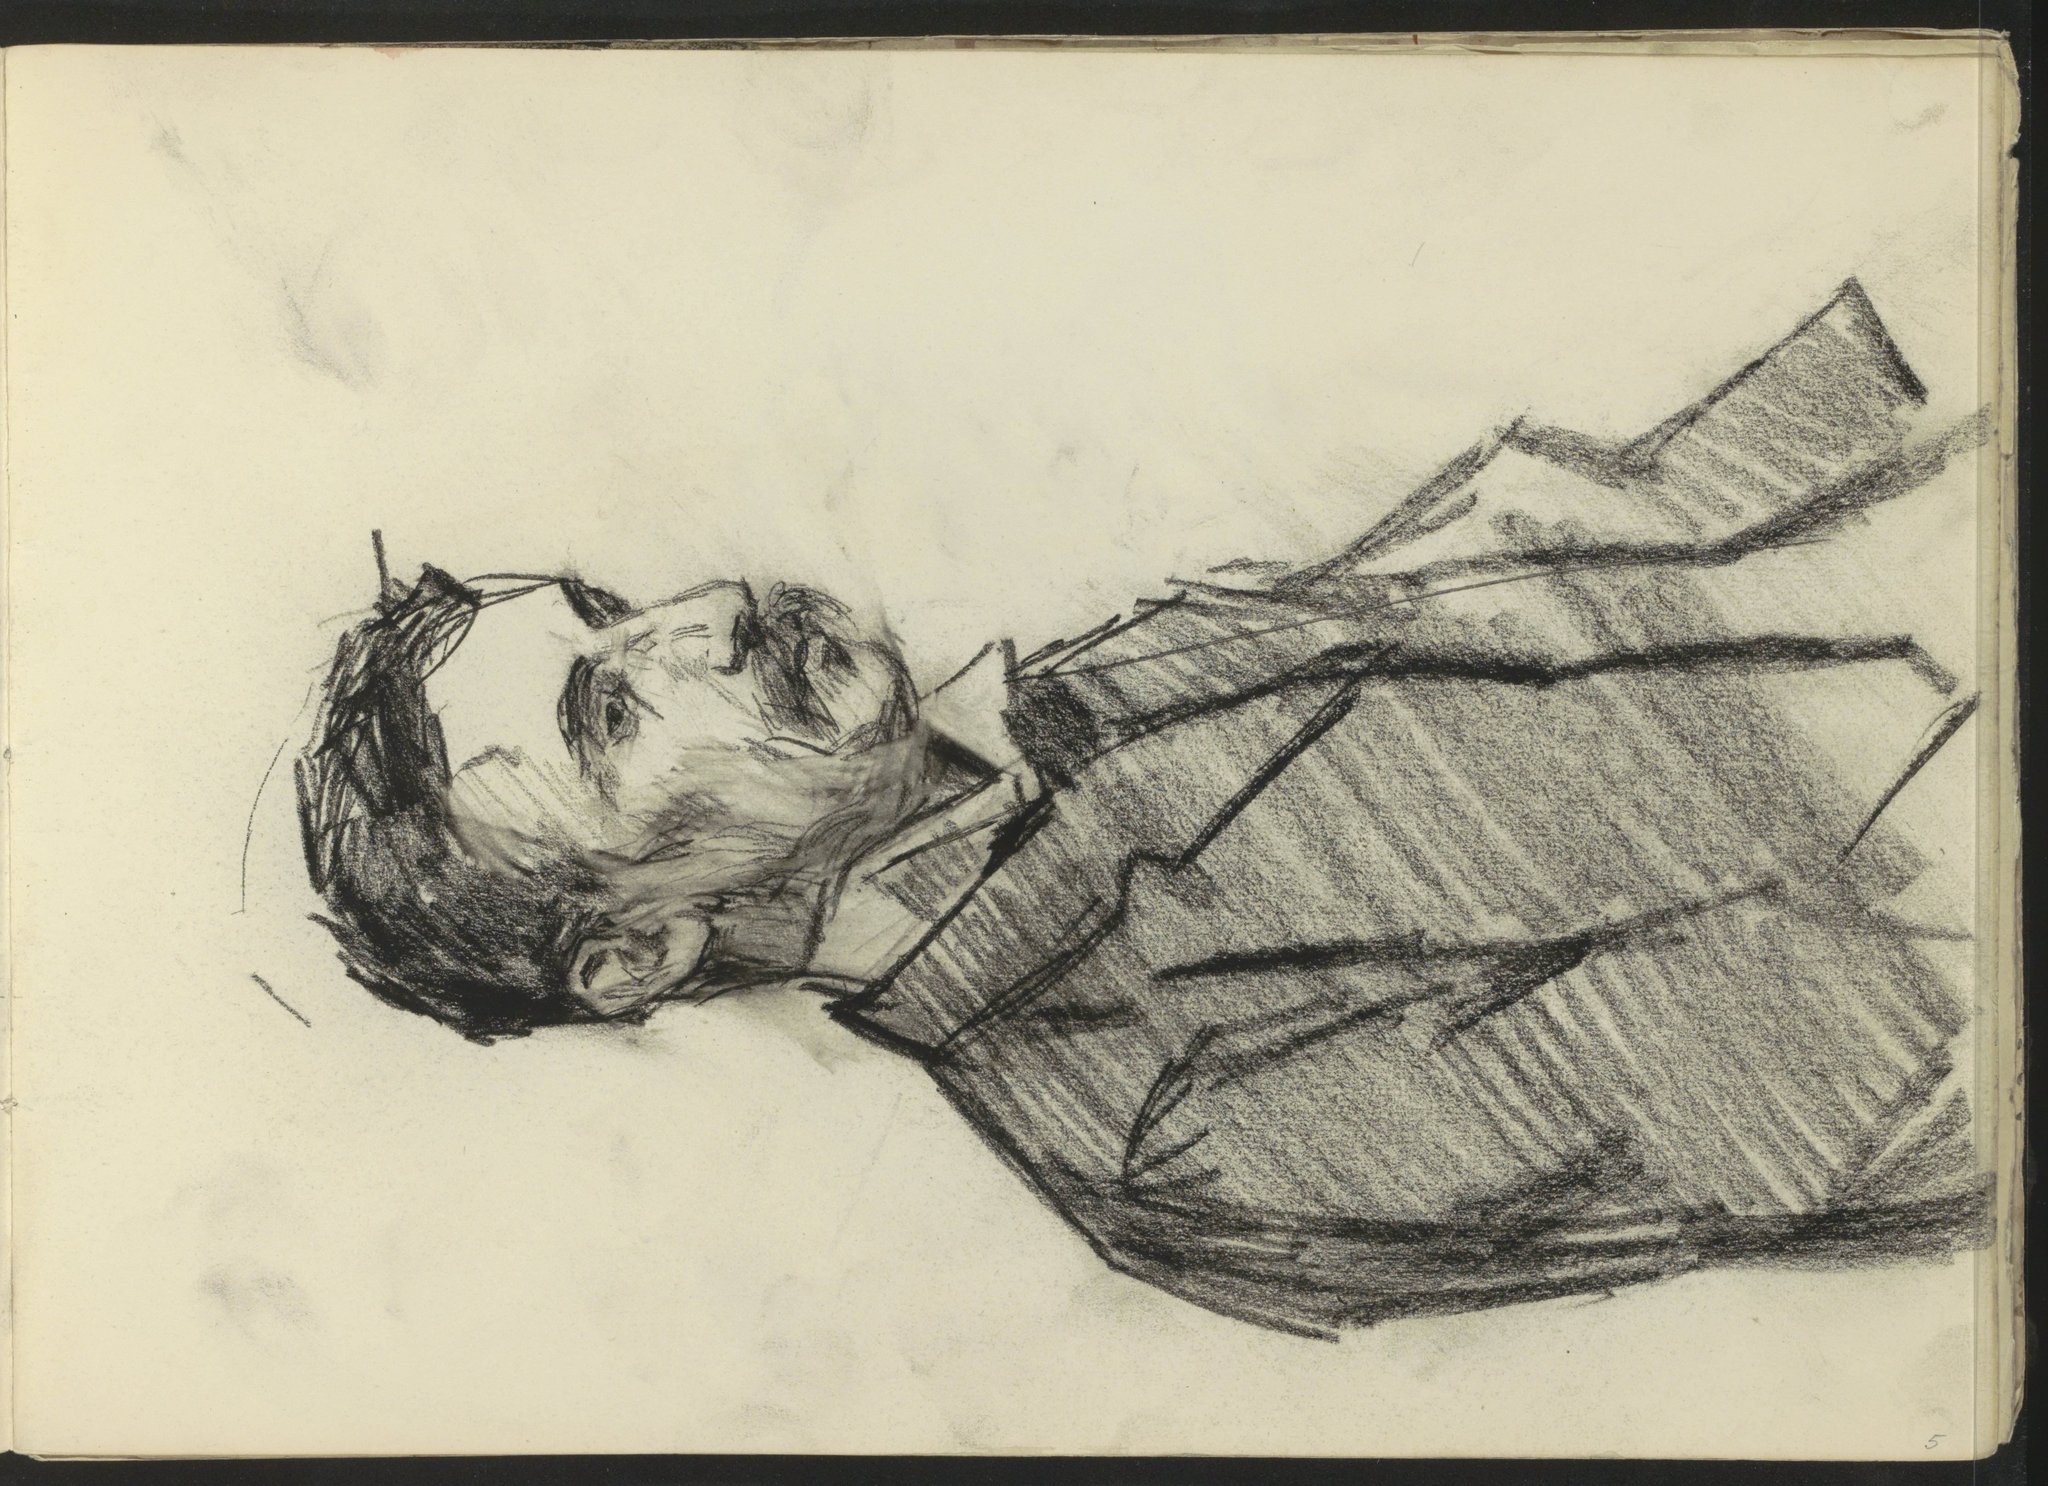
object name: sketchbook leaf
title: Man met snor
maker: isaac israels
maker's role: draughtsman, painter, print maker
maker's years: 1865-1934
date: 1875-1934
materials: chalk, paper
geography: the hague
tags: moustache, adult man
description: Blad 5 recto uit schetsboek XII met 19 bladen.